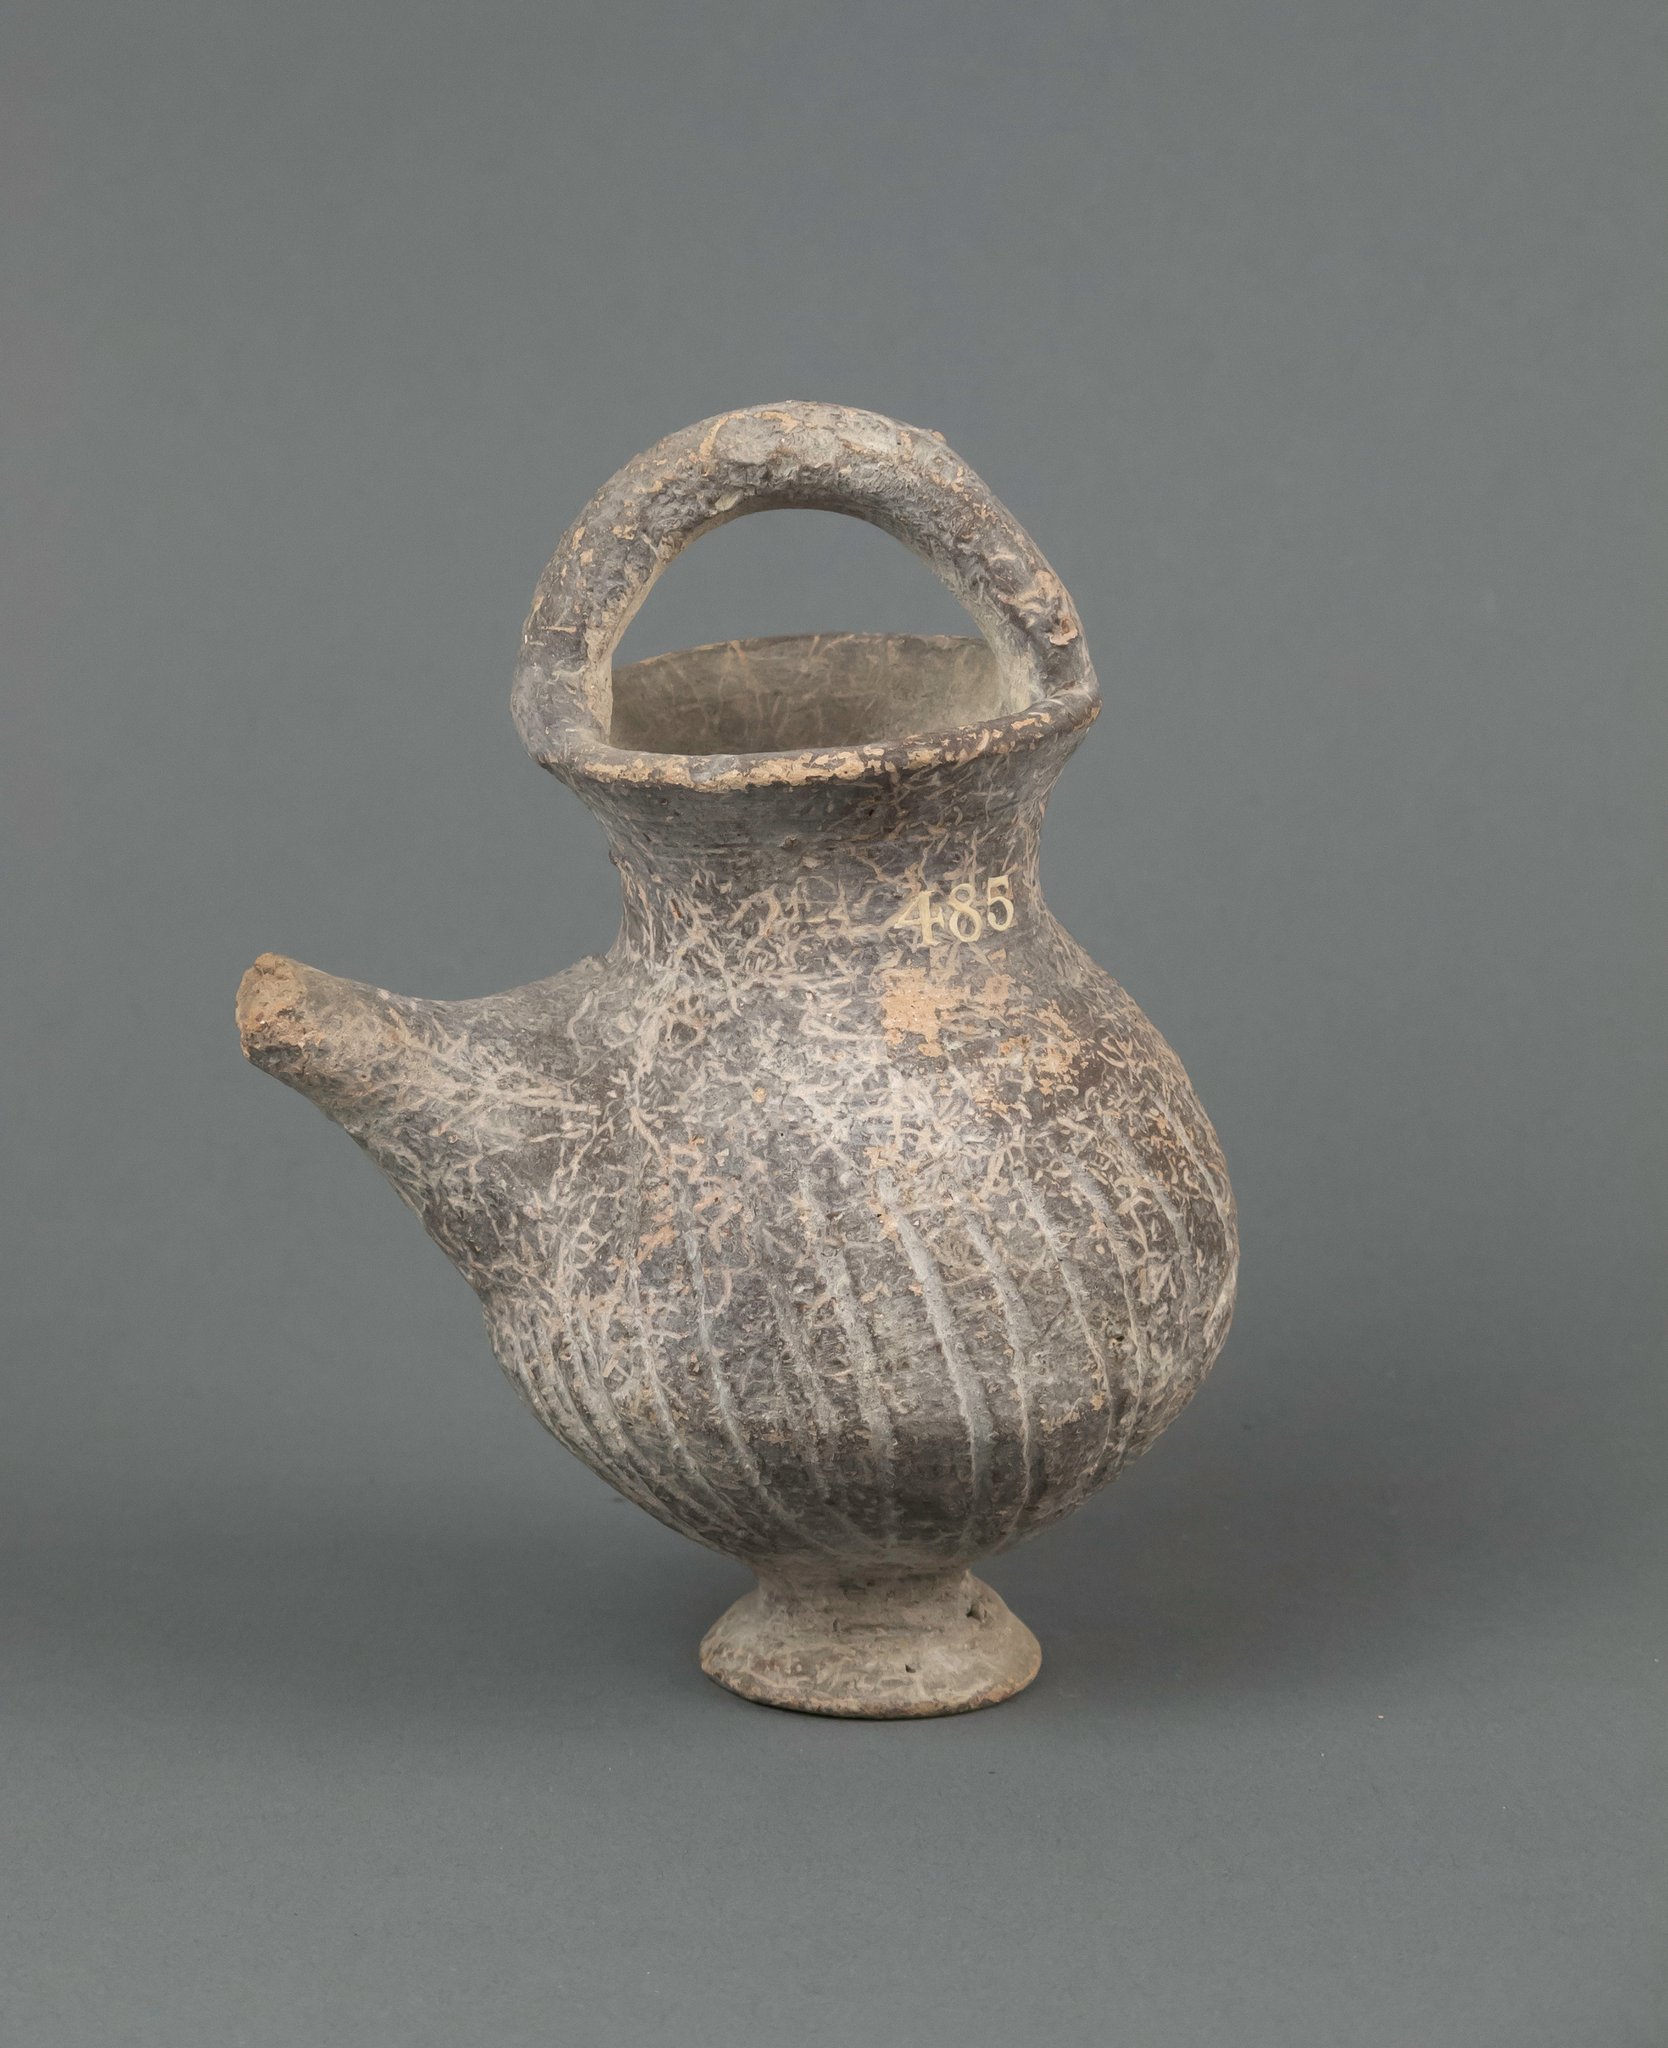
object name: baby feeder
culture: cypriot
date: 1050-950 BCE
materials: terracotta